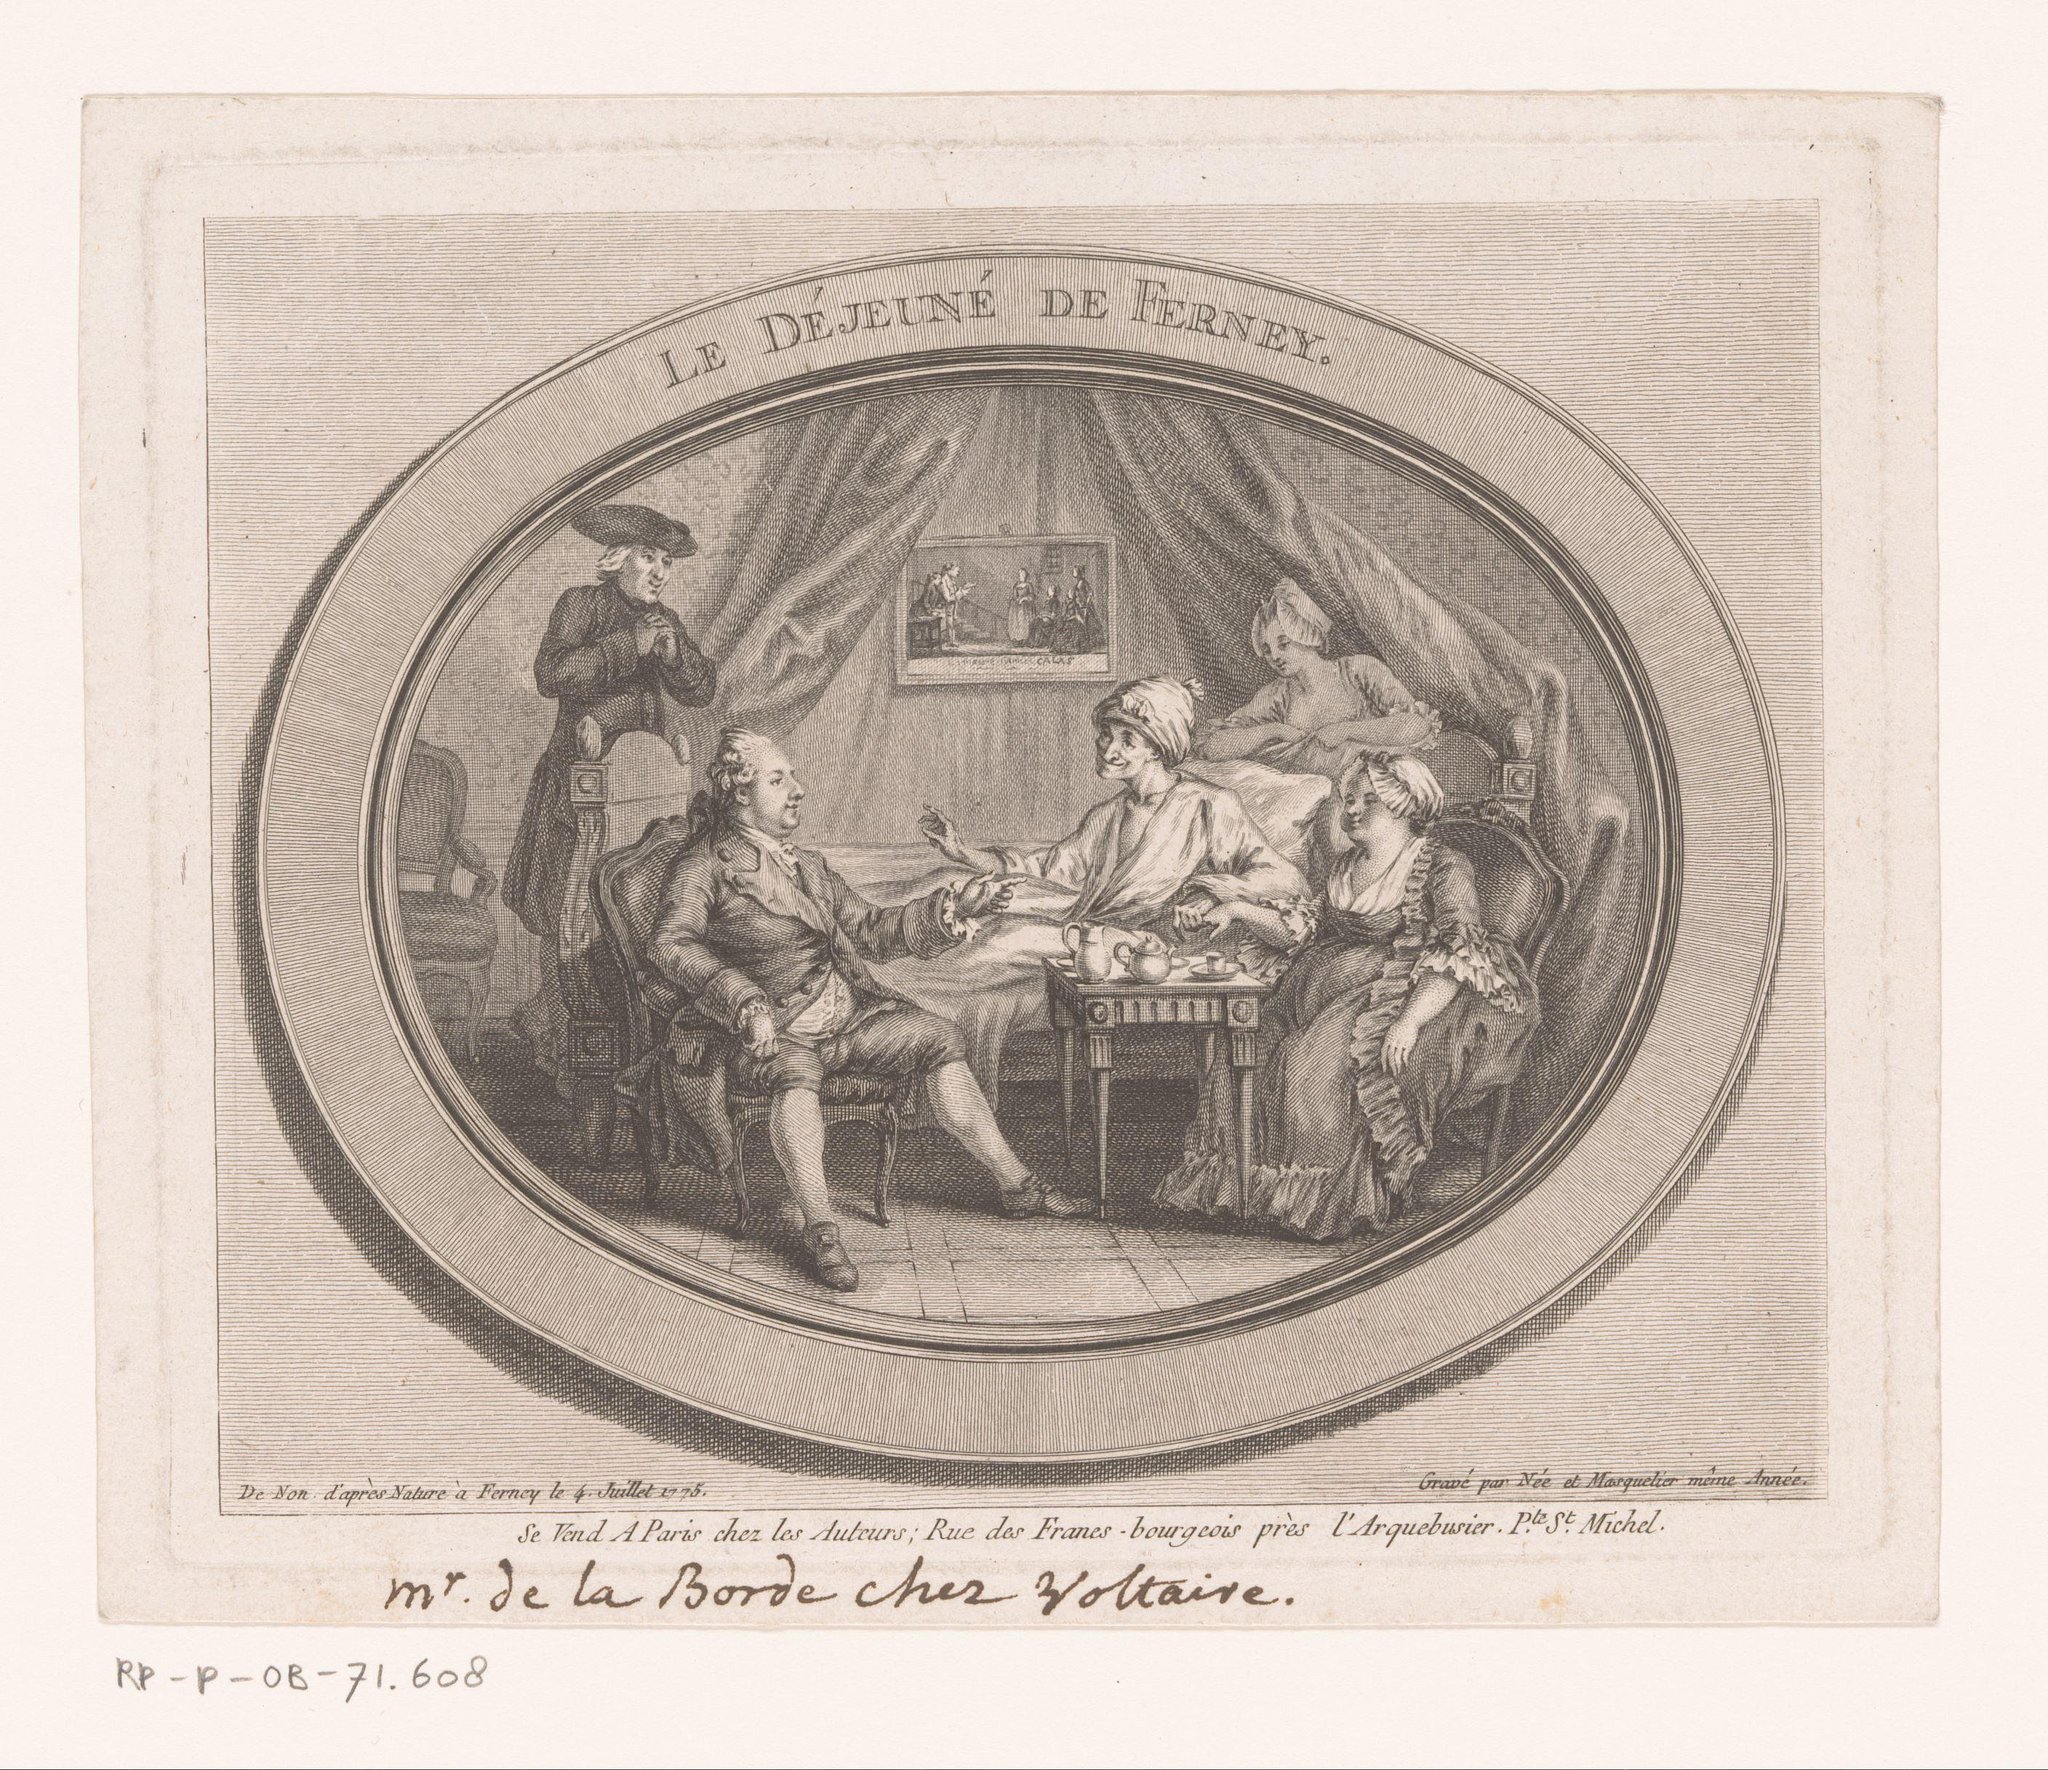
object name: print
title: Le Déjeuné de Ferney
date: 1775-1811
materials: paper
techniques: engraving, etching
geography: paris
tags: paris, voltaire, historical persons, midday meal, lunch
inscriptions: inscription: ‘Mr. de la Borde chez Voltaire.’, collector's mark: Lugt 2228